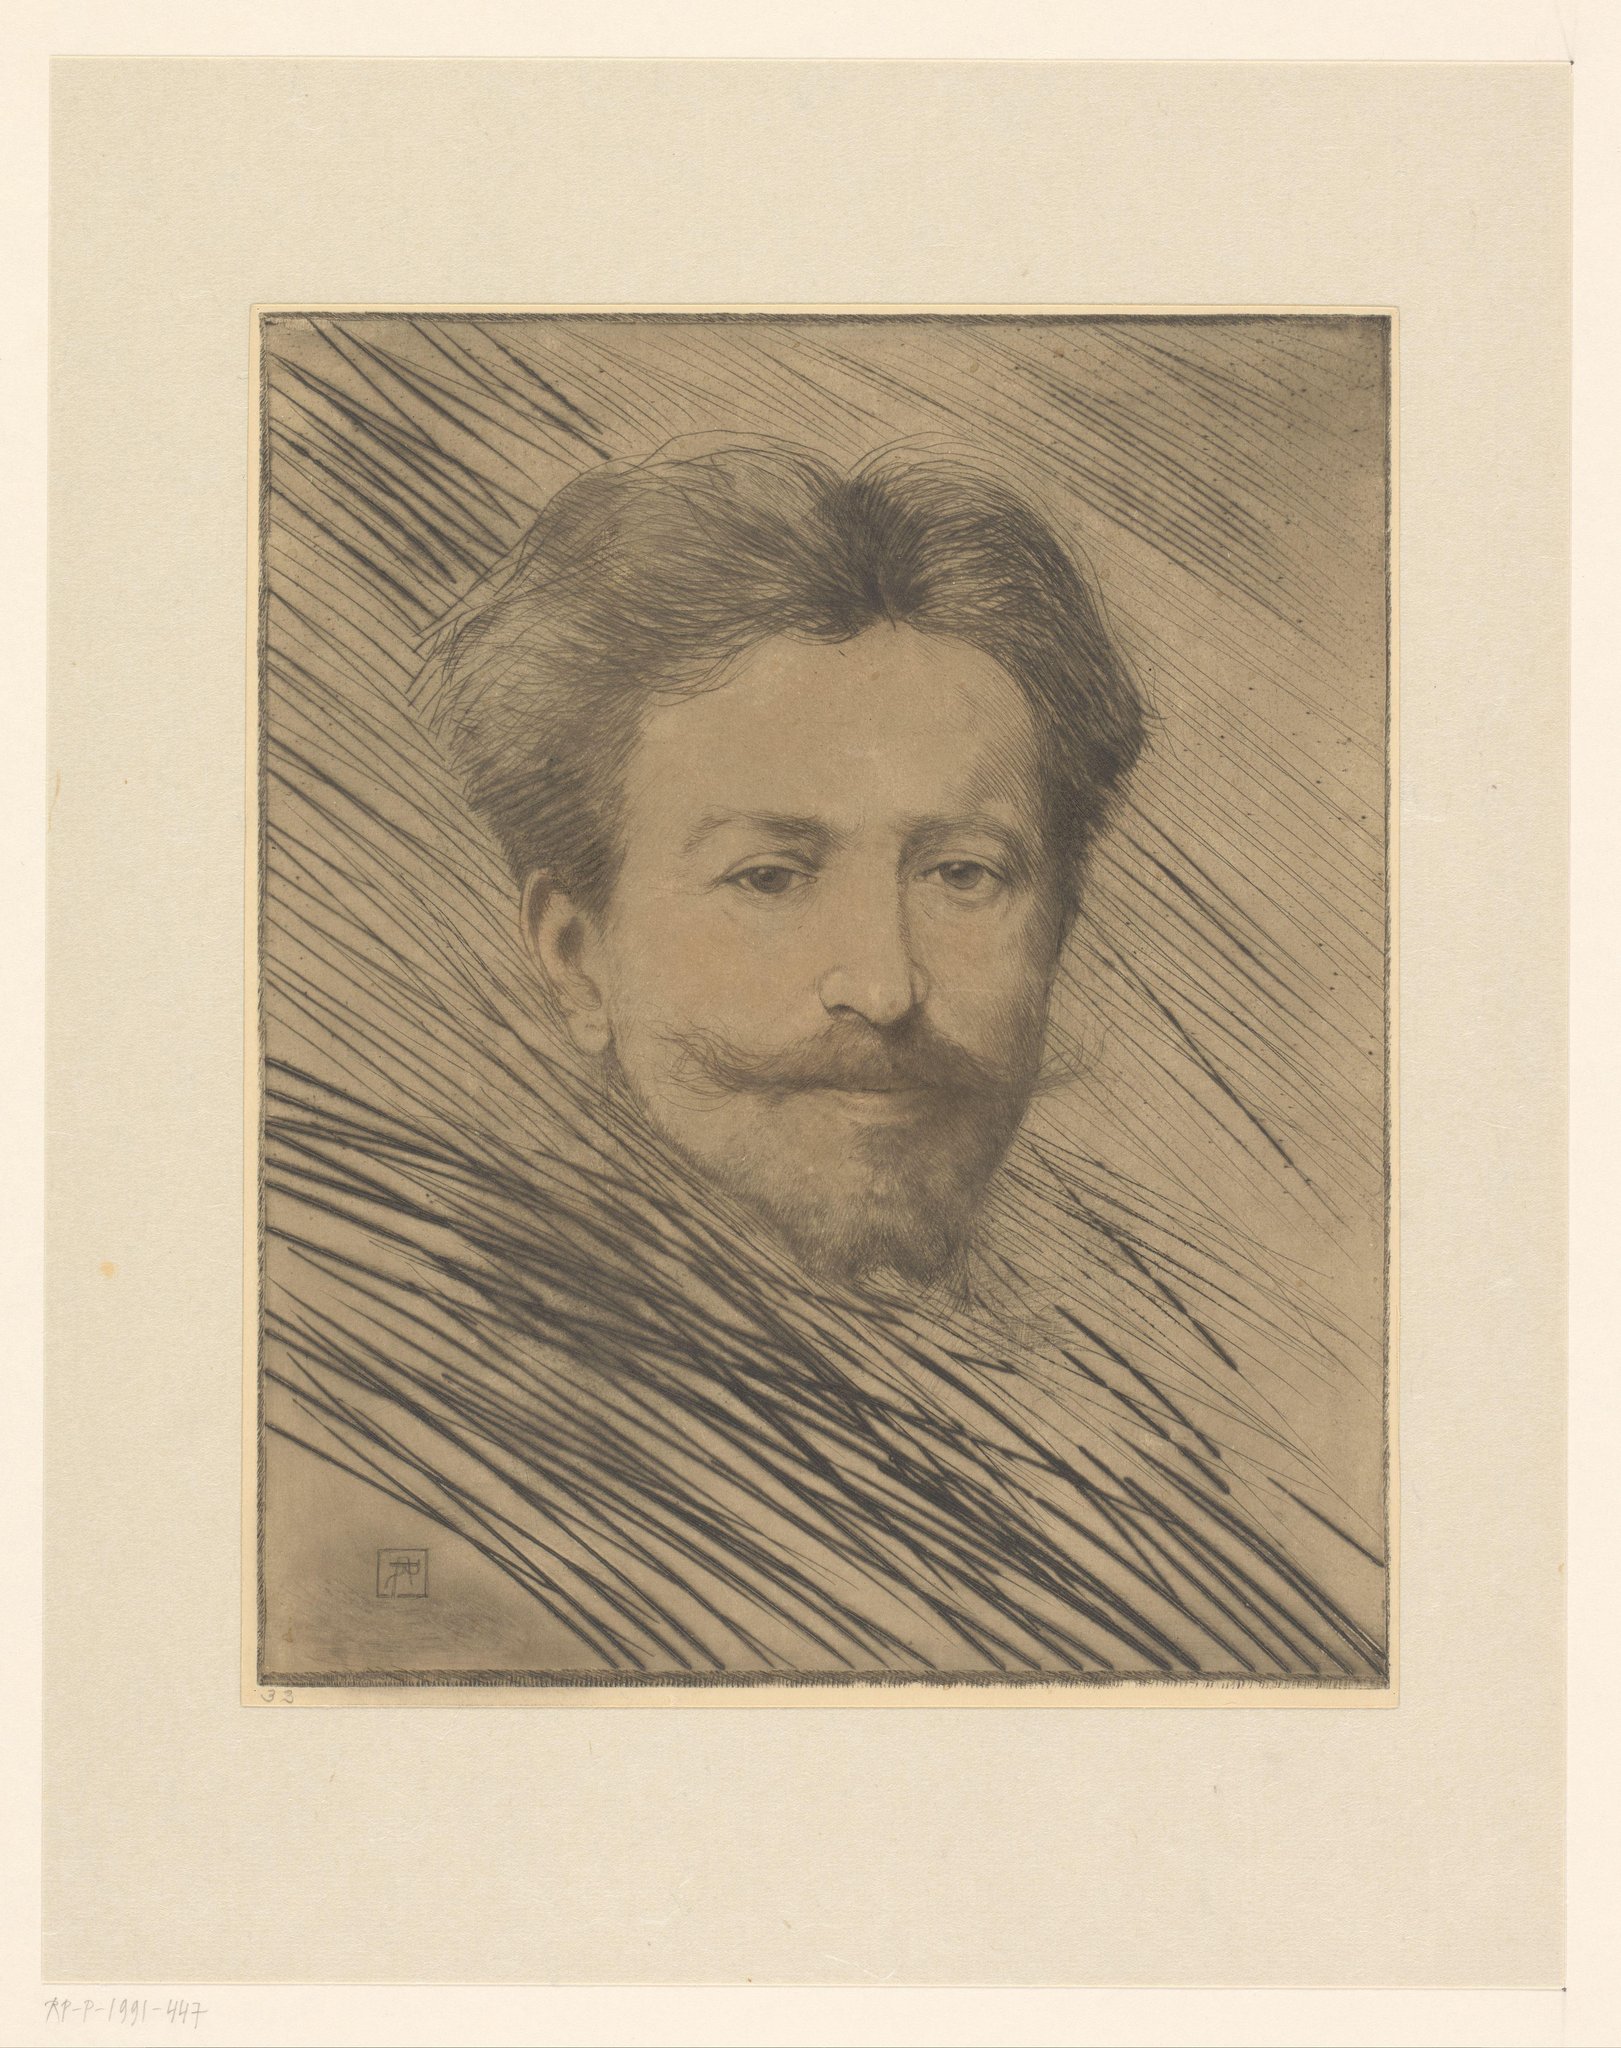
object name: print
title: Portret van Félicien Rops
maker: armand rassenfosse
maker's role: draughtsman, painter, print maker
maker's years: 1862-1934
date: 1872-1934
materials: paper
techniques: drypoint, etching, hand coloring, intaglio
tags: print maker, draughtsman, félicien rops, adult man, historical persons, beard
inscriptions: collector's mark: Lugt 2228, collector's mark: Lugt 2760